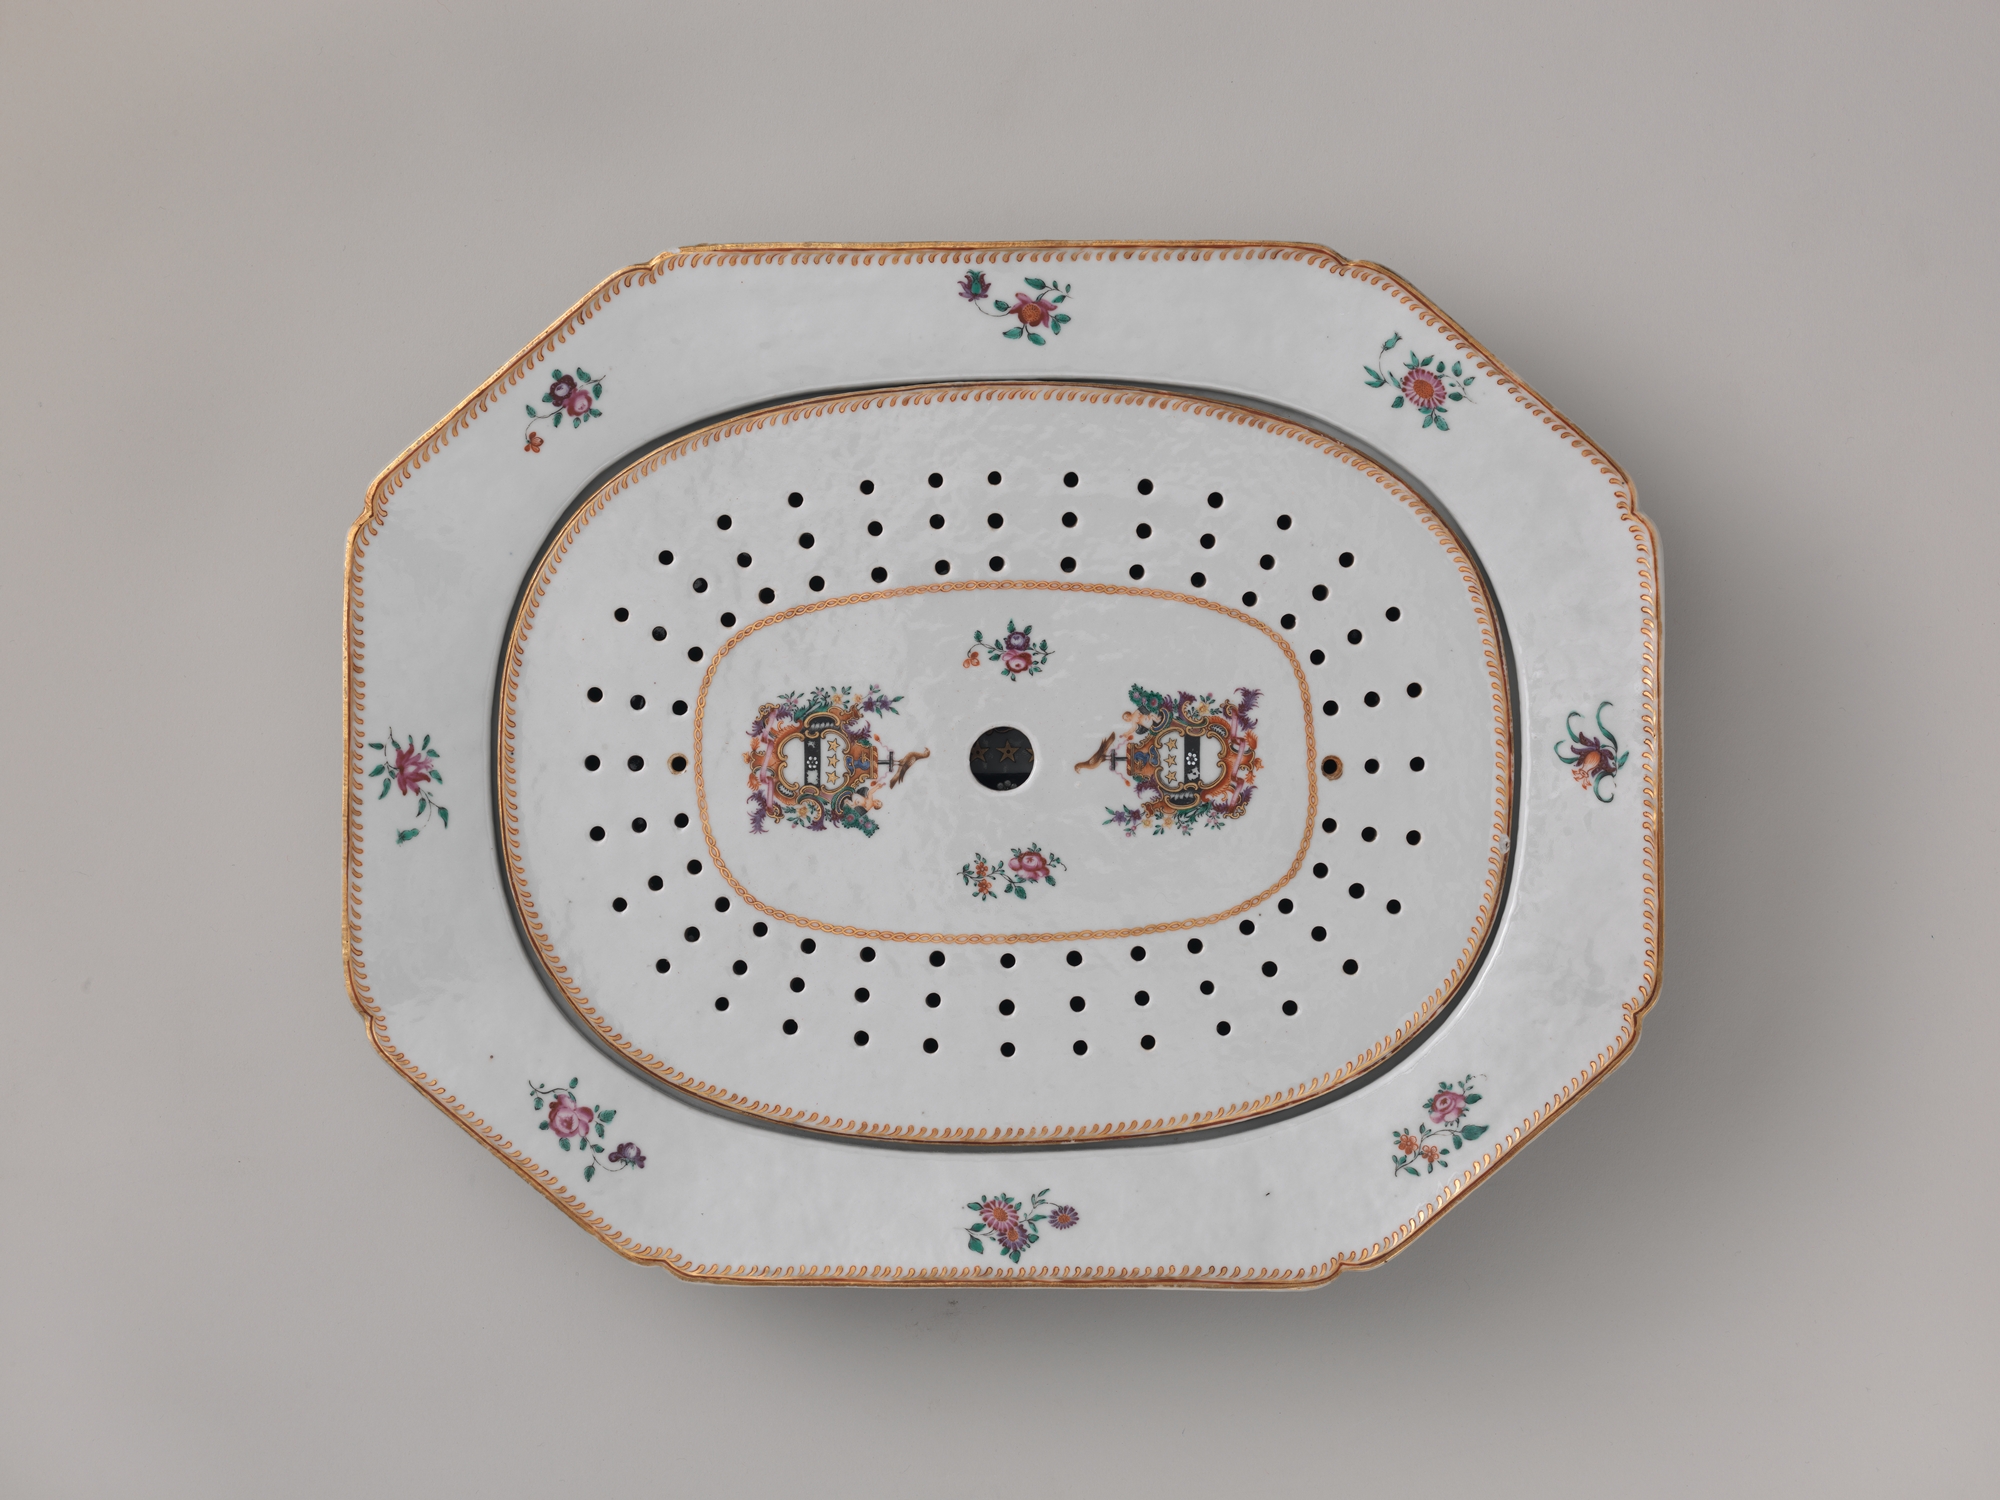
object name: platter with drainer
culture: chinese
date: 1785-1790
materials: porcelain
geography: china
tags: birds,flowers,coat of arms